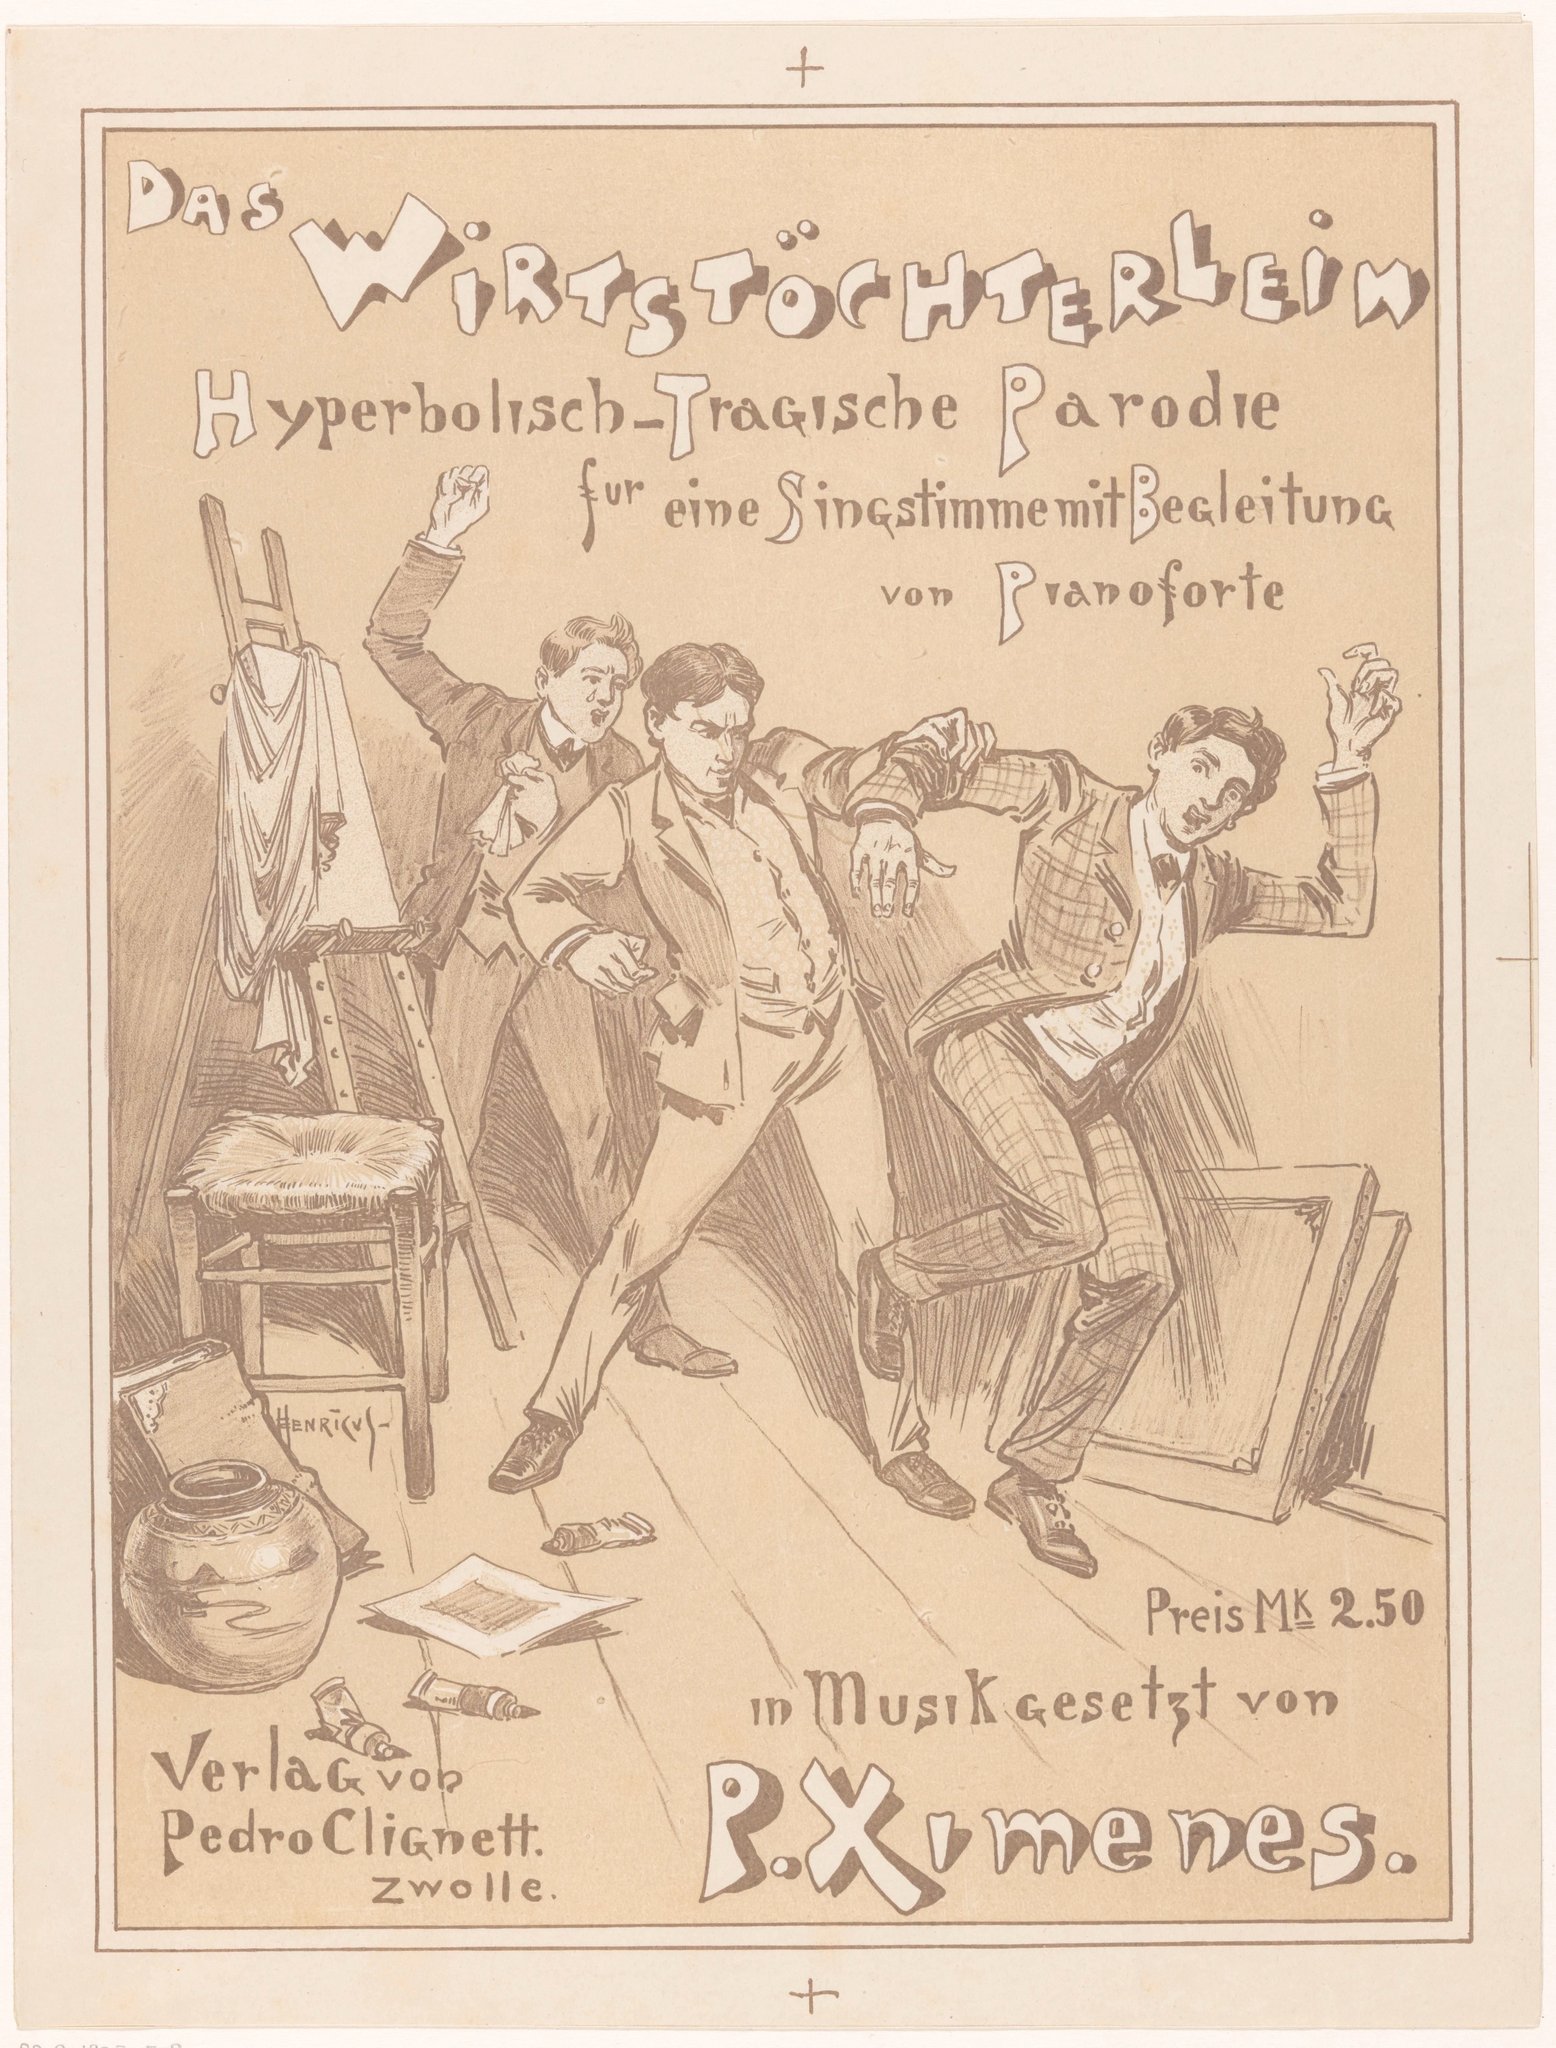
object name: print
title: Das Wirtstöchterlein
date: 1883-1921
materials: paper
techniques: tone lithography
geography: zwolle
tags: studio requisites (artist in general), palette, quarrel, argument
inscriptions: collector's mark: Lugt 2228, collector's mark: Lugt 2760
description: In het rechter kader drie mannen tussen schilderijen en een schildersezel. De middelste man grijpt de rechter man bij zijn arm; de achterste man heft zijn vuist. In het linker kader een ornamentrand met bladeren en een palet.